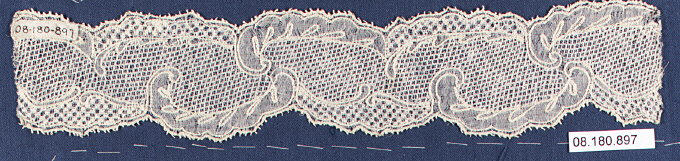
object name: band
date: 1701-1800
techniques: embroidery